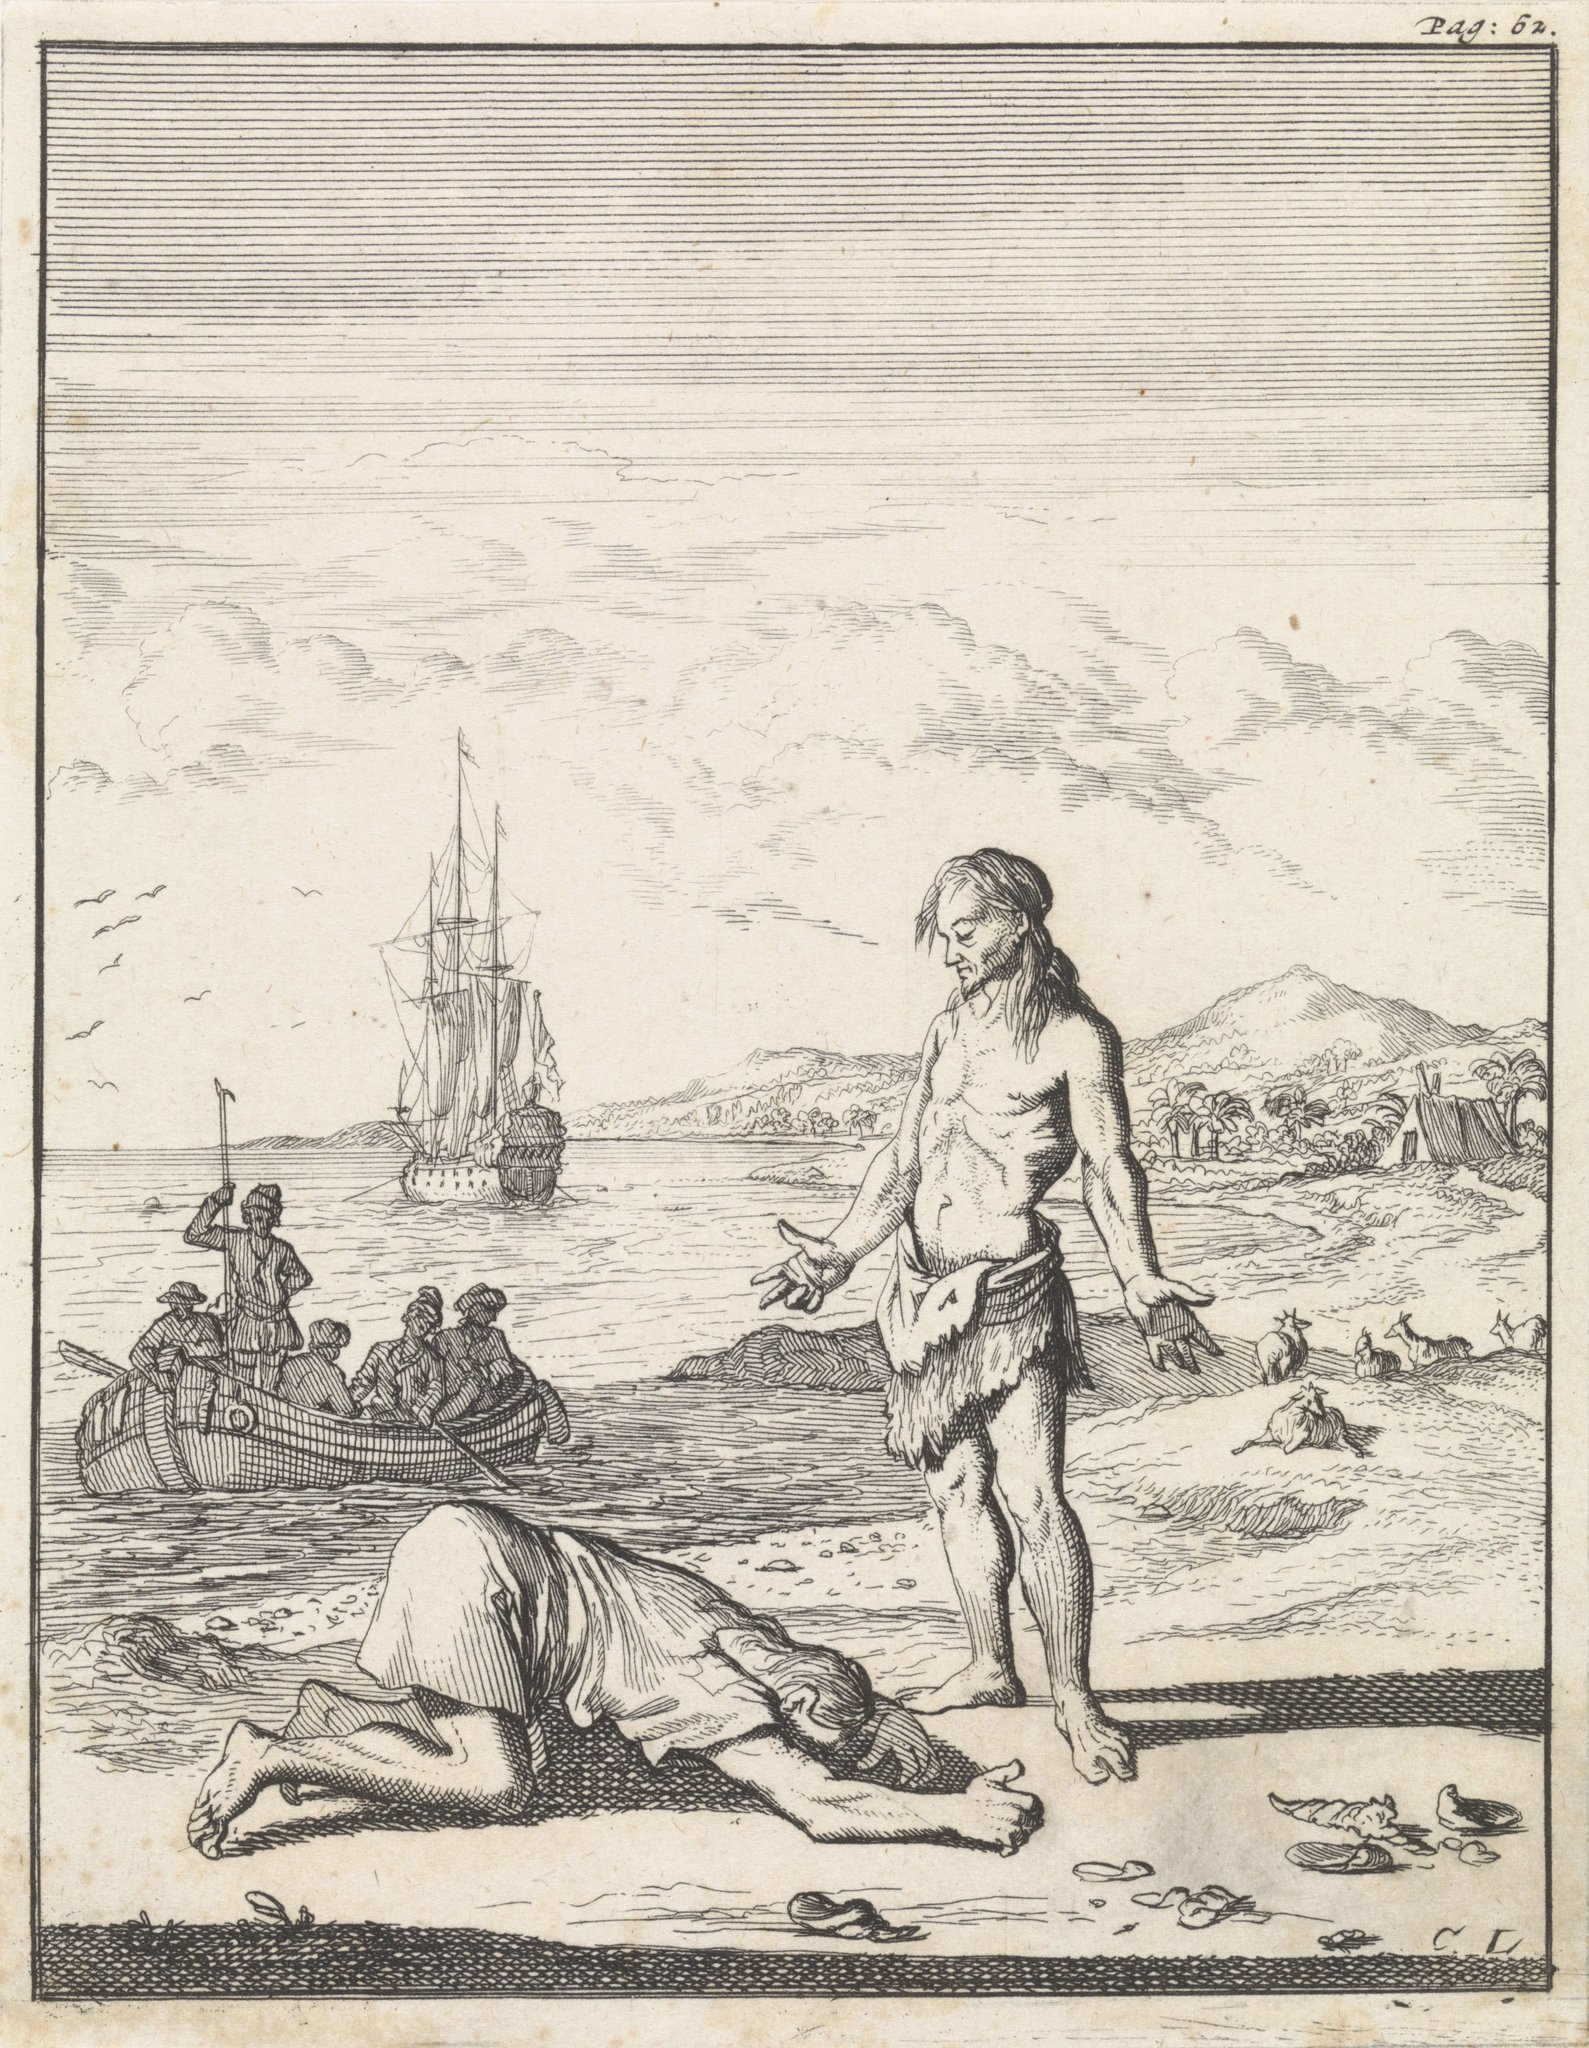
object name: book illustration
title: Ontmoeting tussen twee Miskitomannen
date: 1698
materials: paper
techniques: etching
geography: the hague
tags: making a bow to a ruler (+ variant), indigenous peoples of south america, landscapes in the non-temperate zone, exotic landscapes, rowing-boat, canoe, etc., indigenous peoples of central america, exploration, expedition, voyage of discovery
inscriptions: collector's mark: Lugt 2228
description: Op het strand van Juan Fernández (Chili) valt een Miskitoman ter begroeting aan de voeten van een staande Miskitoman. In de branding kijkt een groep Europeanen vanuit een roeiboot toe. De Miskito kwamen oorspronkelijk uit Honduras en Nicaragua.